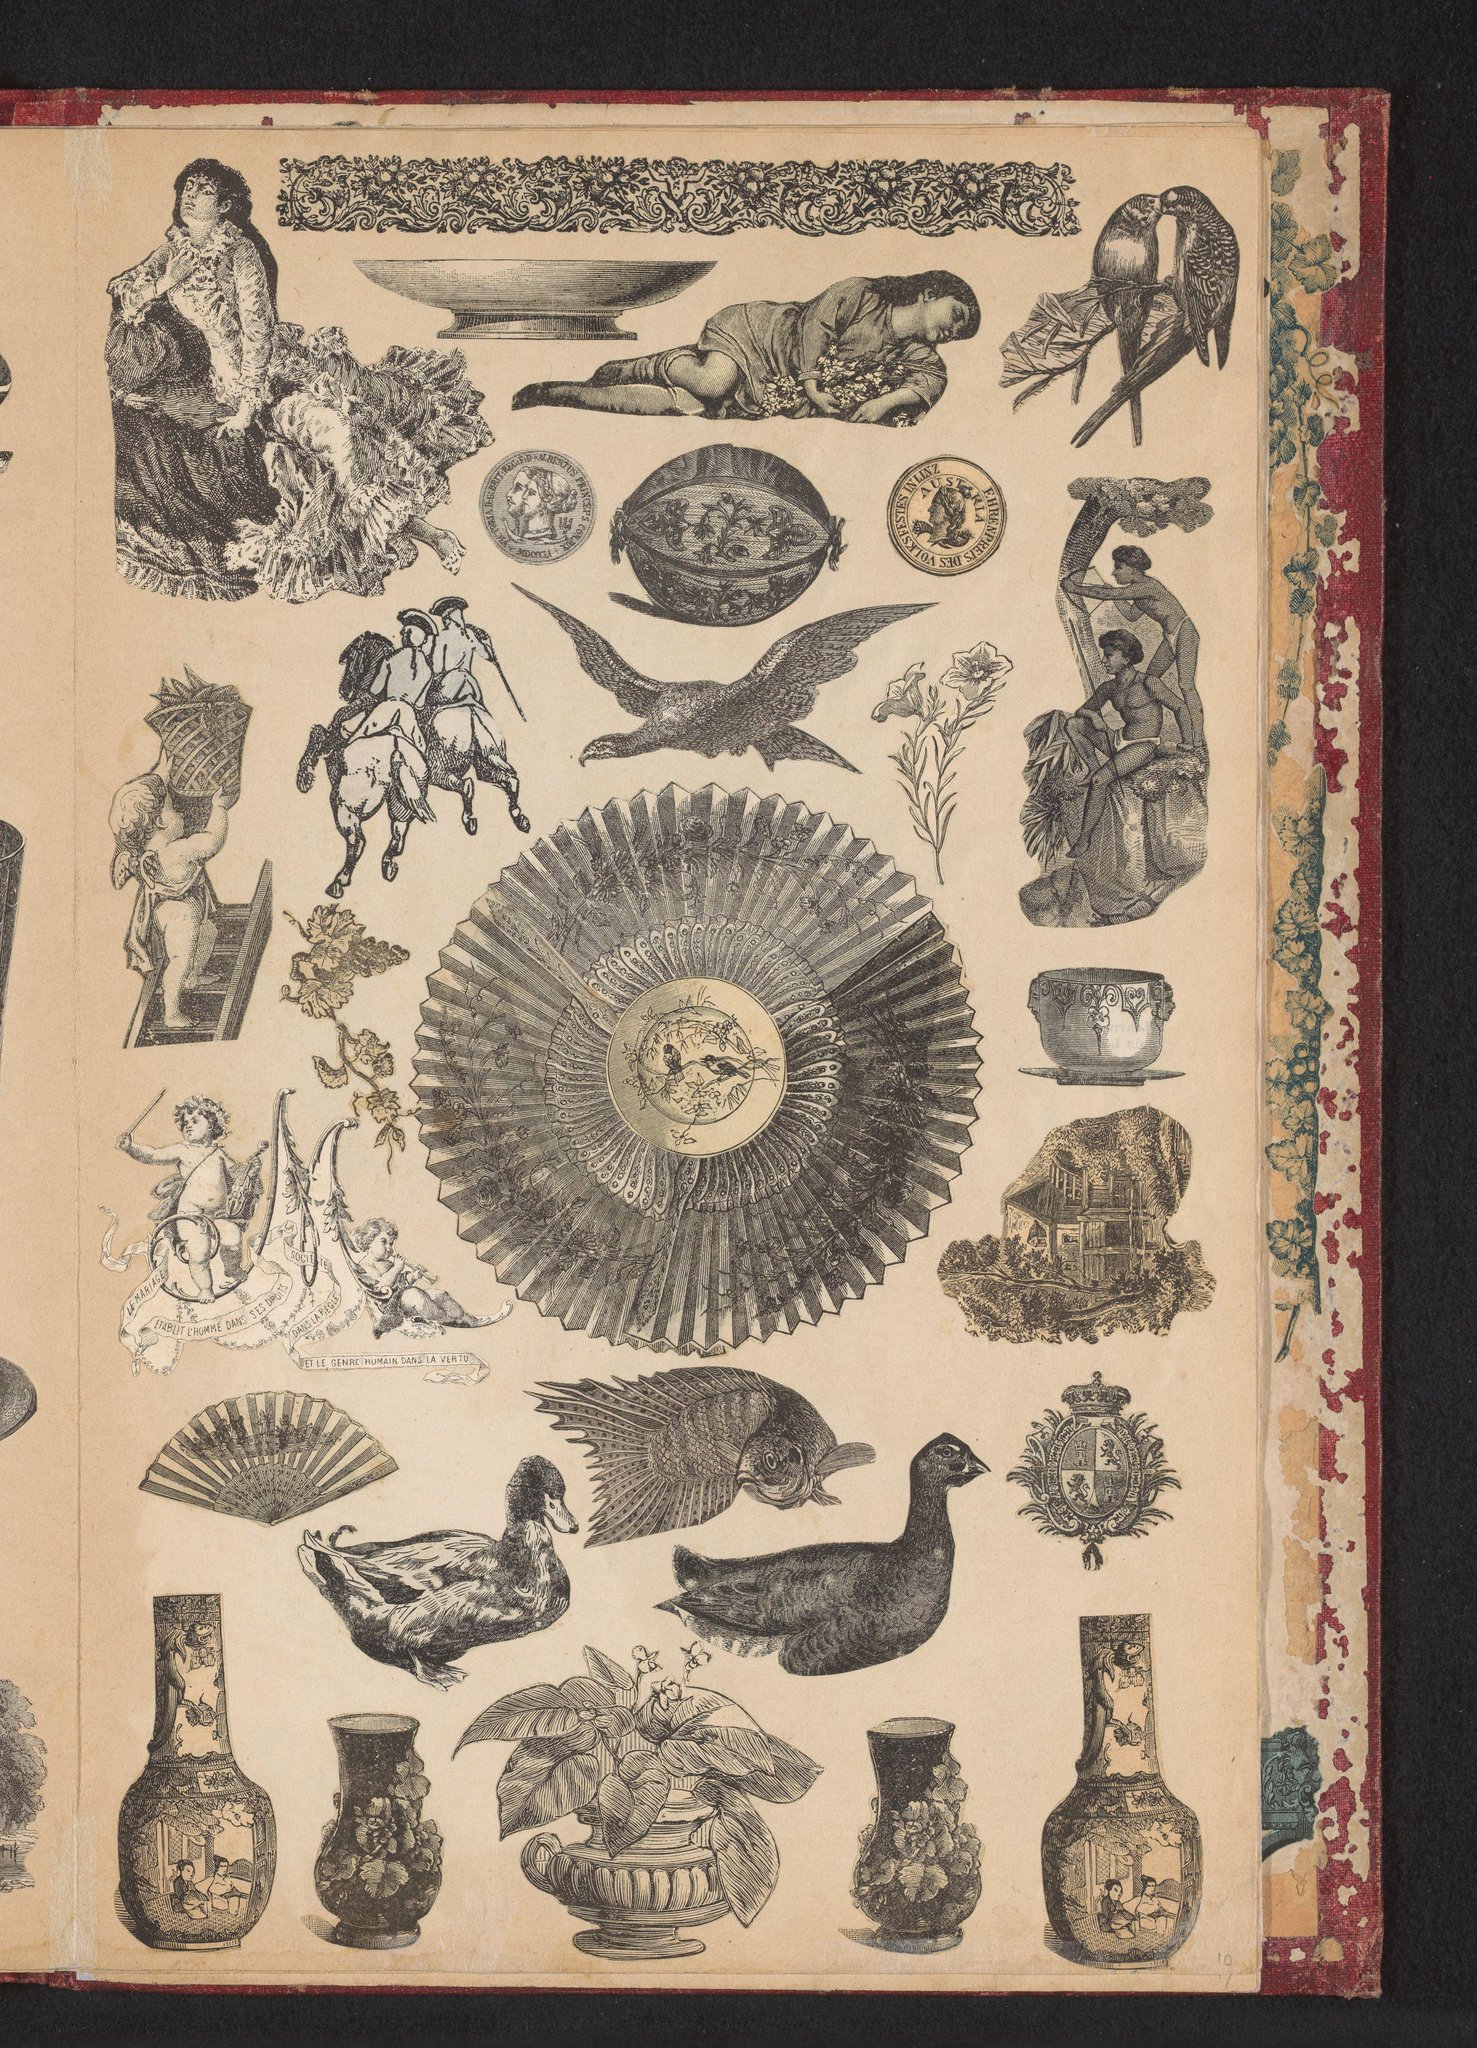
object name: collage visual work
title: Collage van uitgeknipte prenten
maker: Anonymous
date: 1870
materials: paper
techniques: engraving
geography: paris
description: Collage van uitgeknipte prenten. Onderdeel van een album met 18 bladen, aan beide zijden beplakt met uitgeknipte prenten, vermoedelijk afkomstig uit 19e-eeuwse tijdschiften.